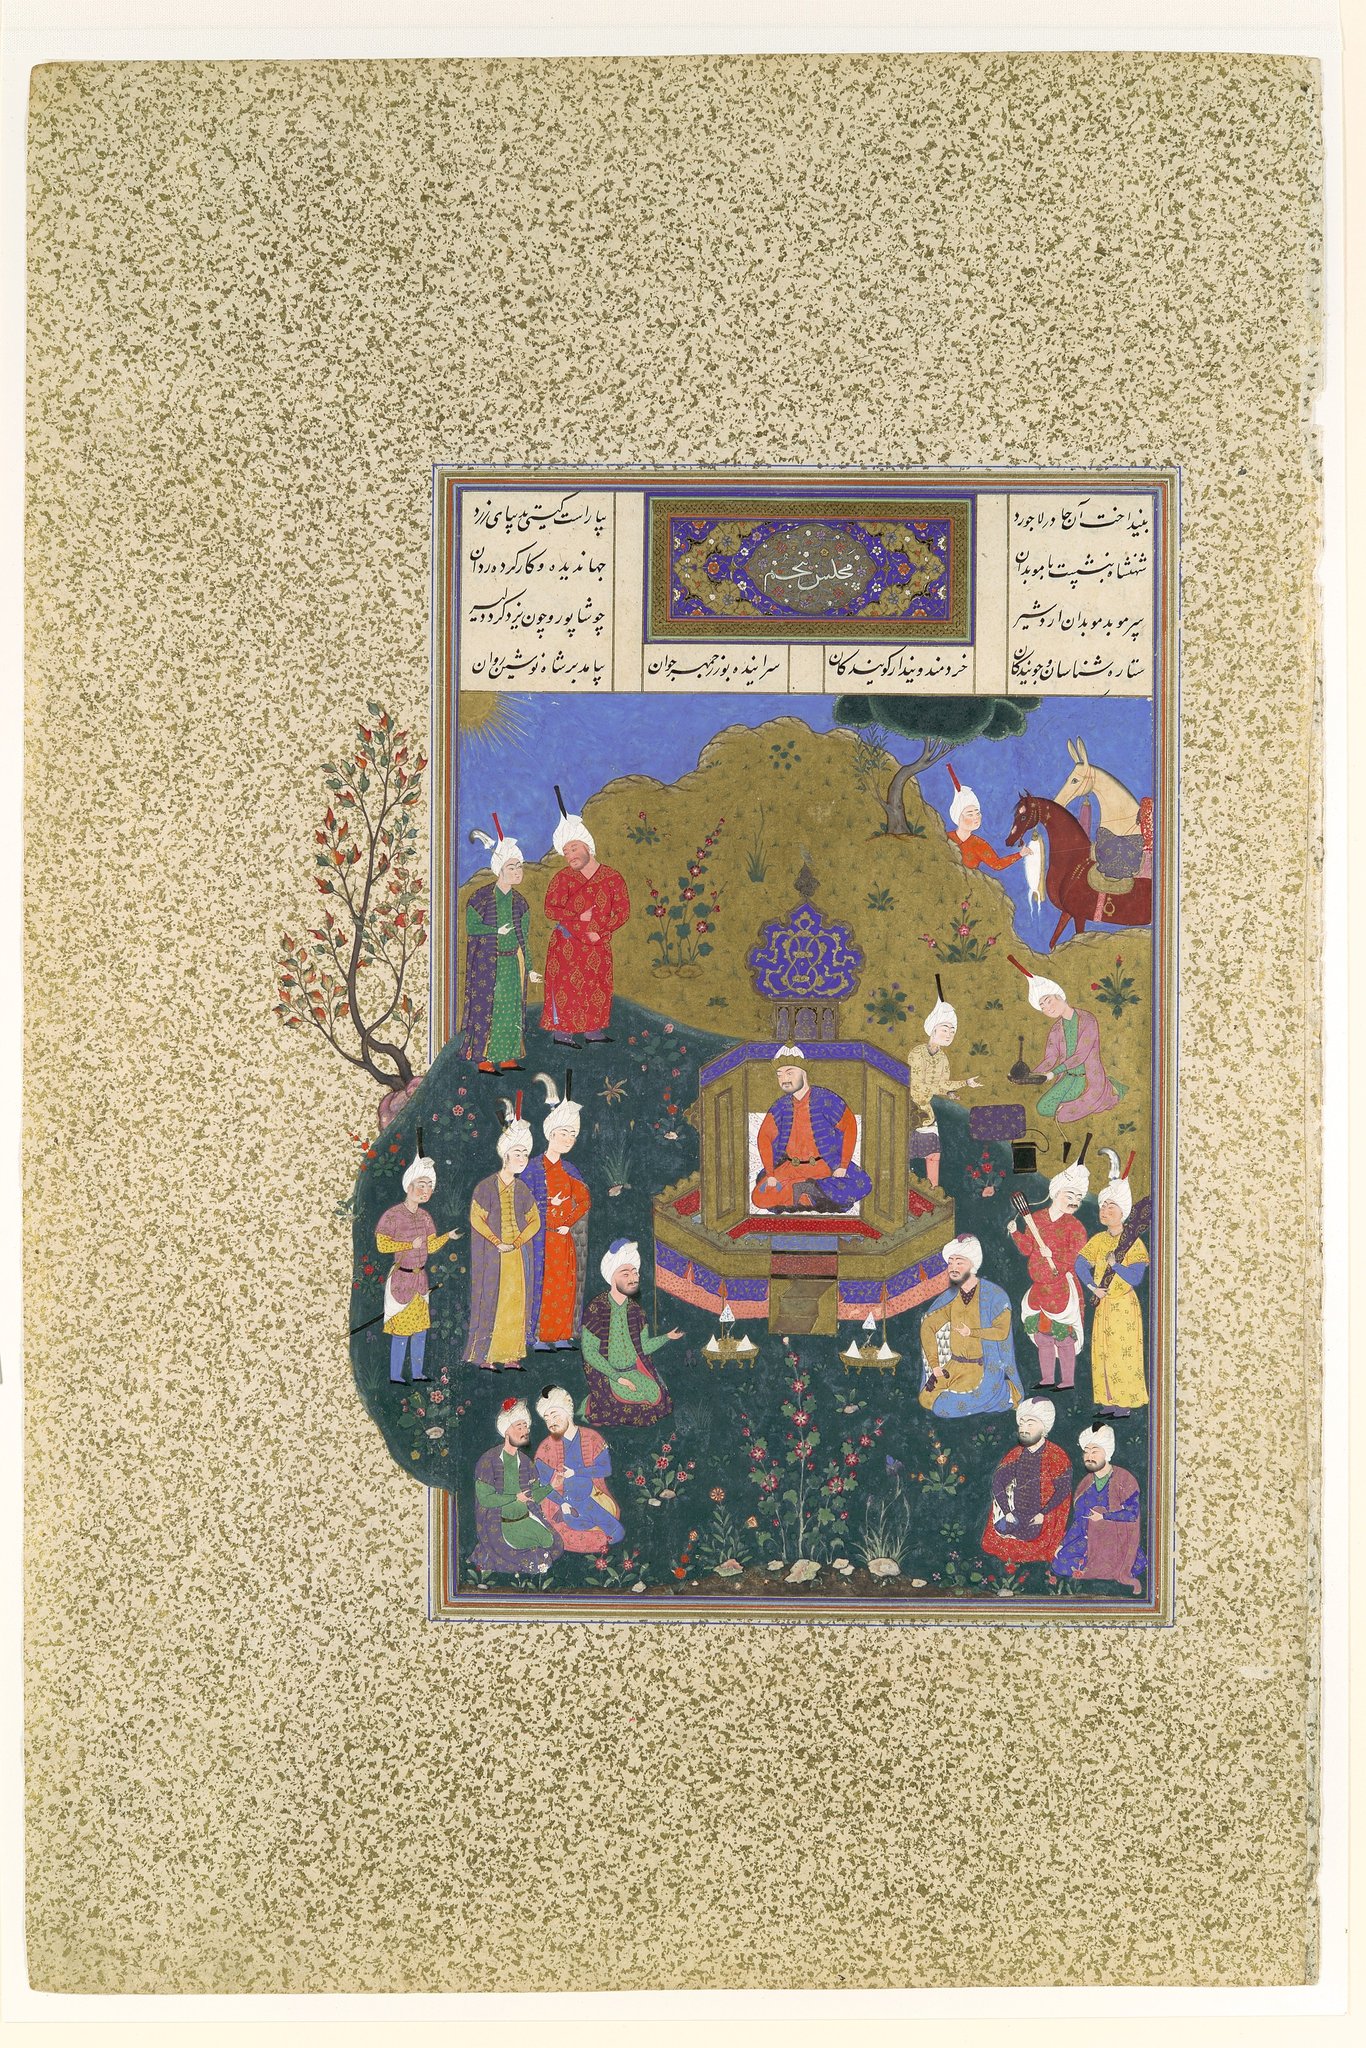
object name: folio from an illustrated manuscript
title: "Buzurjmihr Appears at Nushirvan's Fifth Assembly", Folio 622r from the Shahnama (Book of Kings) of Shah Tahmasp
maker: abu'l qasim firdausi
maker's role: author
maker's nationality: iranian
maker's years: 935-1020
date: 1530-1535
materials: gold, ink, paper, silver, watercolor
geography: iran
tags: men